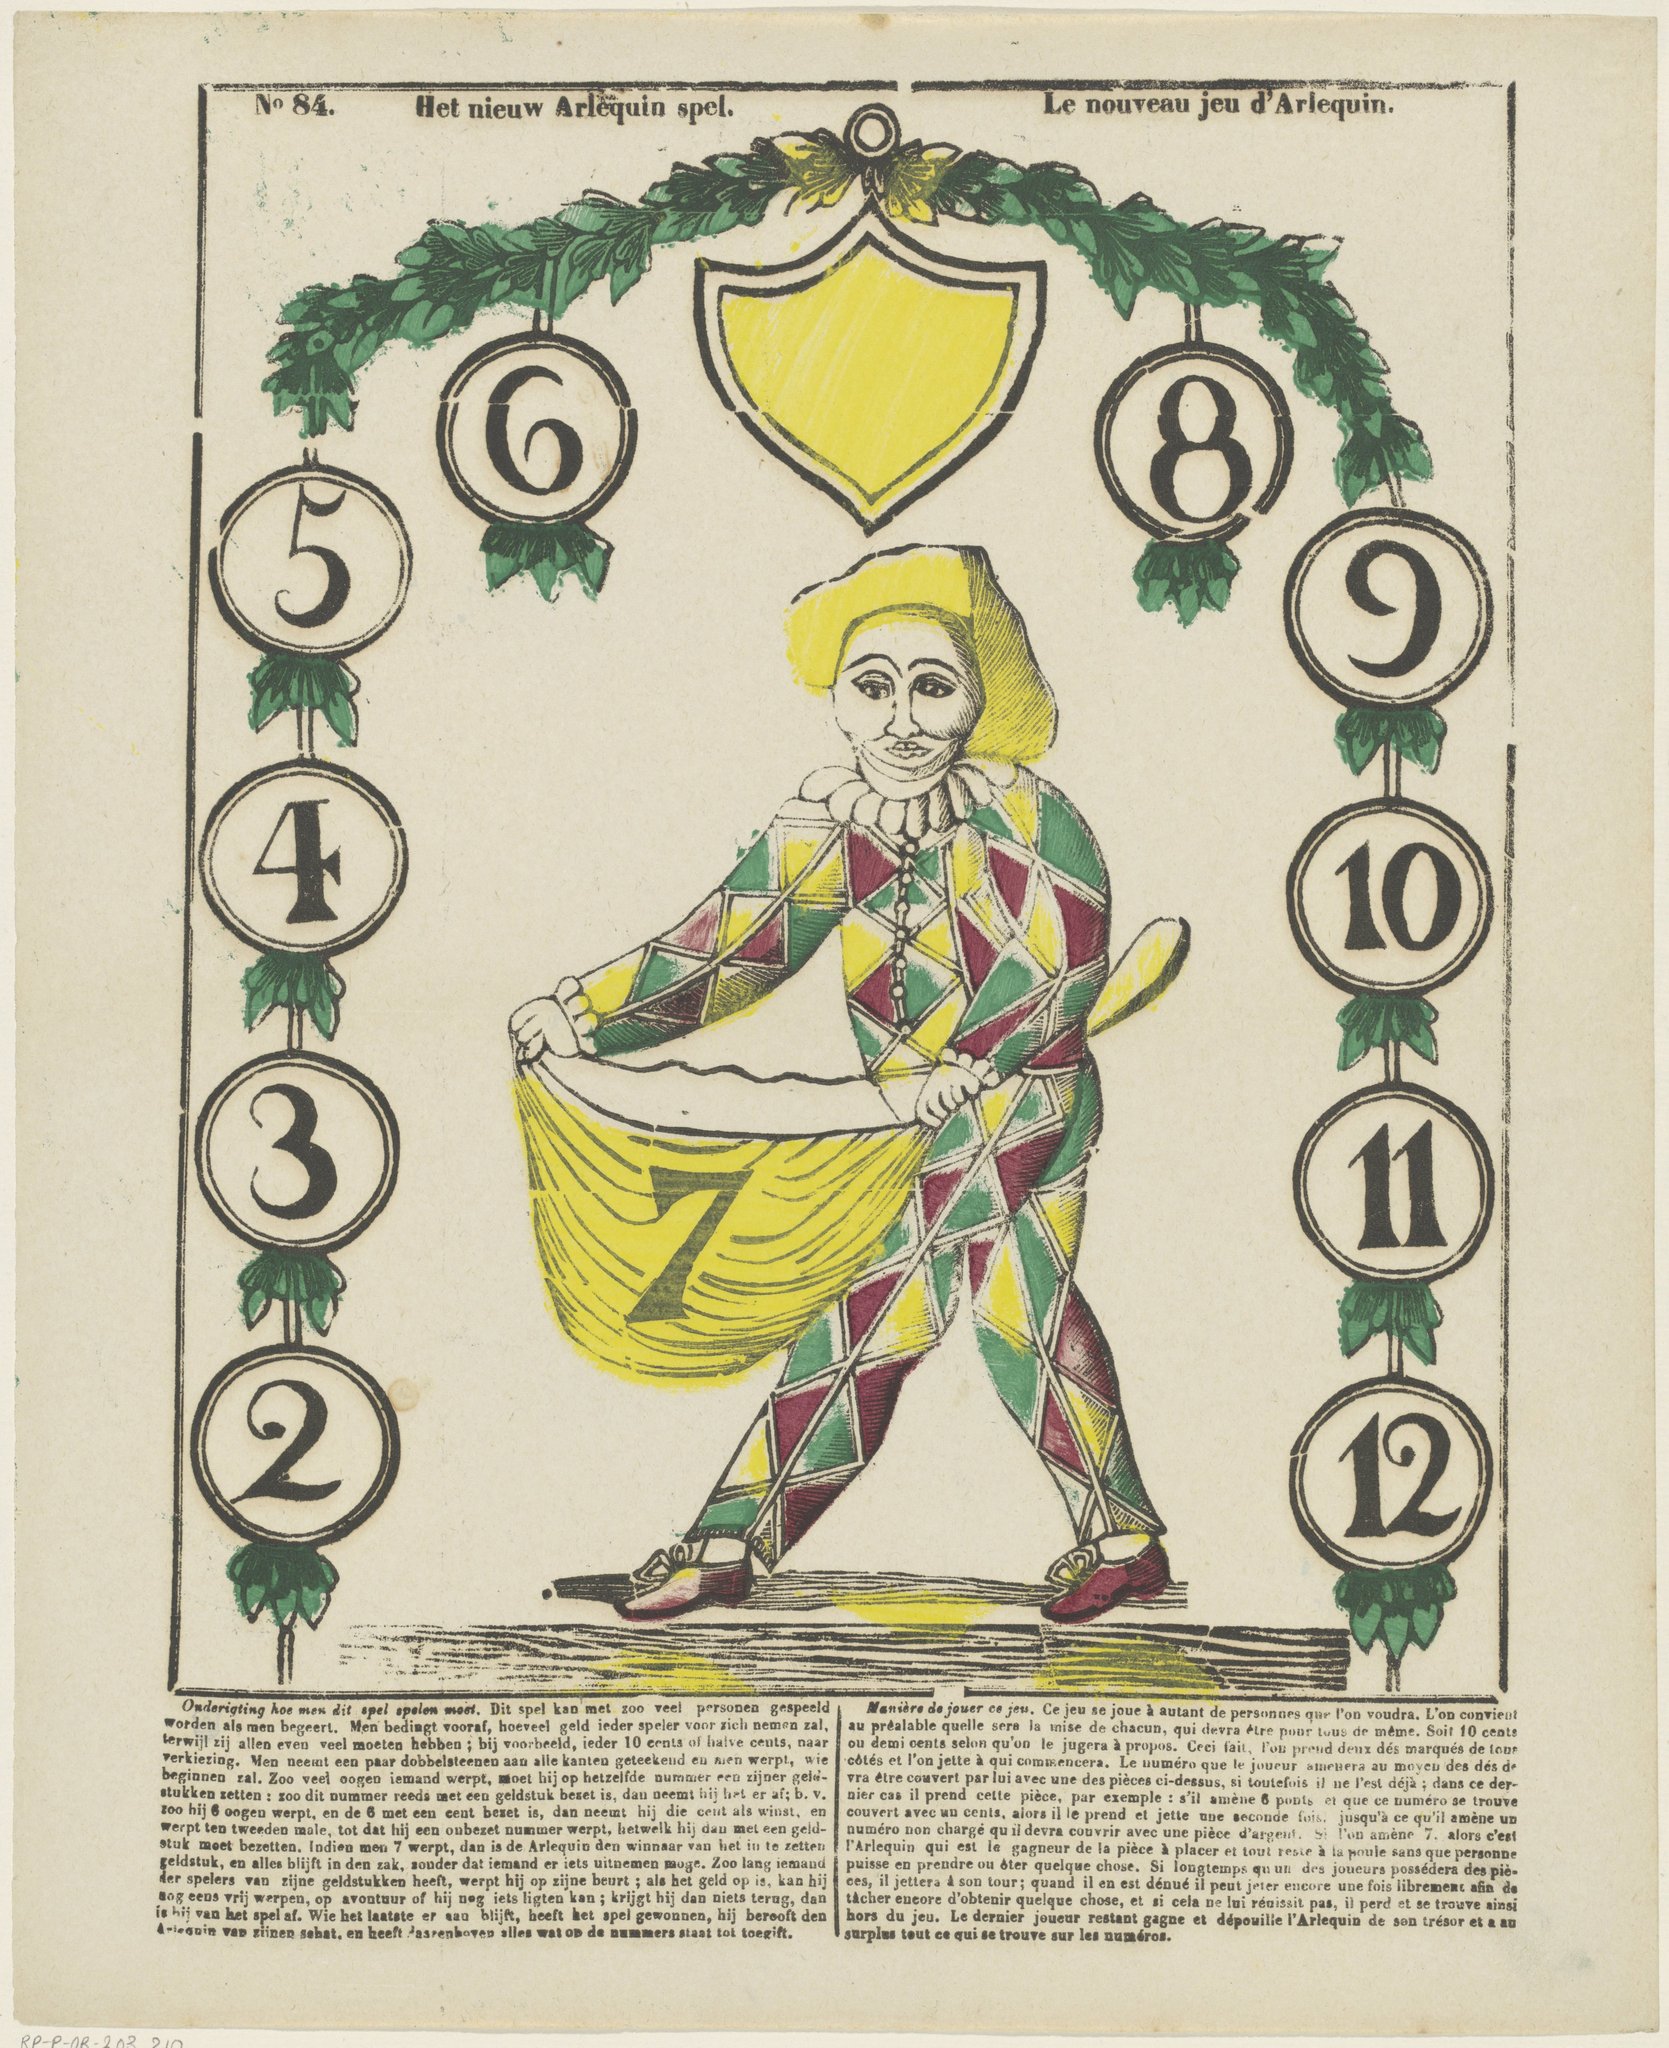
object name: gameboard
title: Het nieuw Arlequin spel / Le nouveau jeu d'Arlequin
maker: Anonymous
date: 1856-1900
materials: paper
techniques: colour, letterpress printing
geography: netherlands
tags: board-games of chance, types in 'commedia dell'arte': harlequin, board-games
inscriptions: collector's mark: Lugt 2760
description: Bordspel met in het midden van het speelveld een harlekijn die in zijn geopende handen een zak houdt met daarop het cijfer 7. Rondom hem een guirlande waaraan medaillons hangen met de cijfers 2 tot en met 12. Bovenaan in het midden een schild. Onder de voorstelling de spelregels in het Nederlands en in het Frans in twee kolommen. Genummerd linksboven: No. 84.